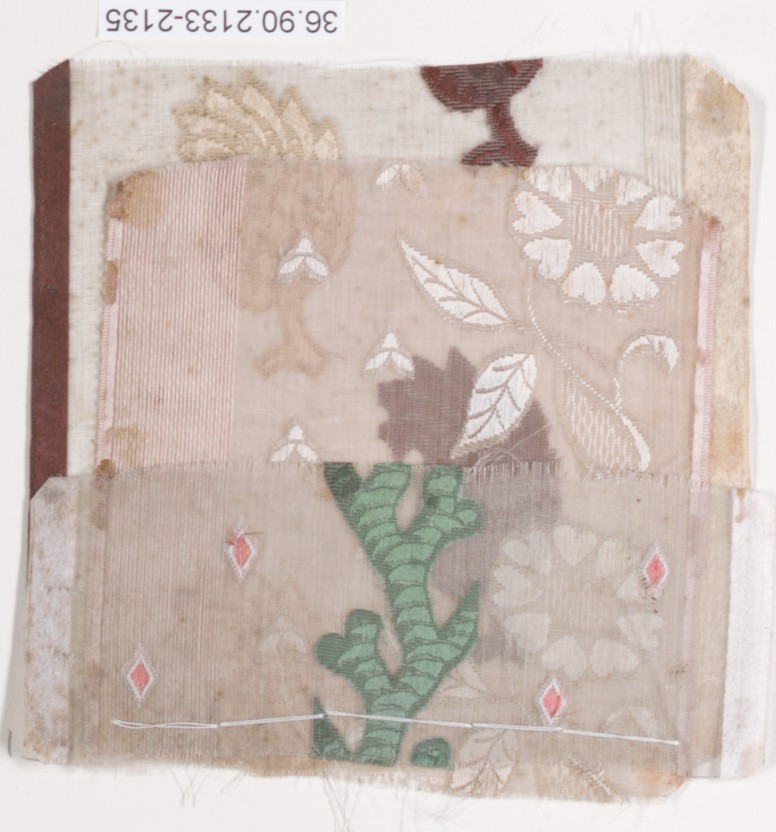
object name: piece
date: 1801-1900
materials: silk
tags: flowers,leaves